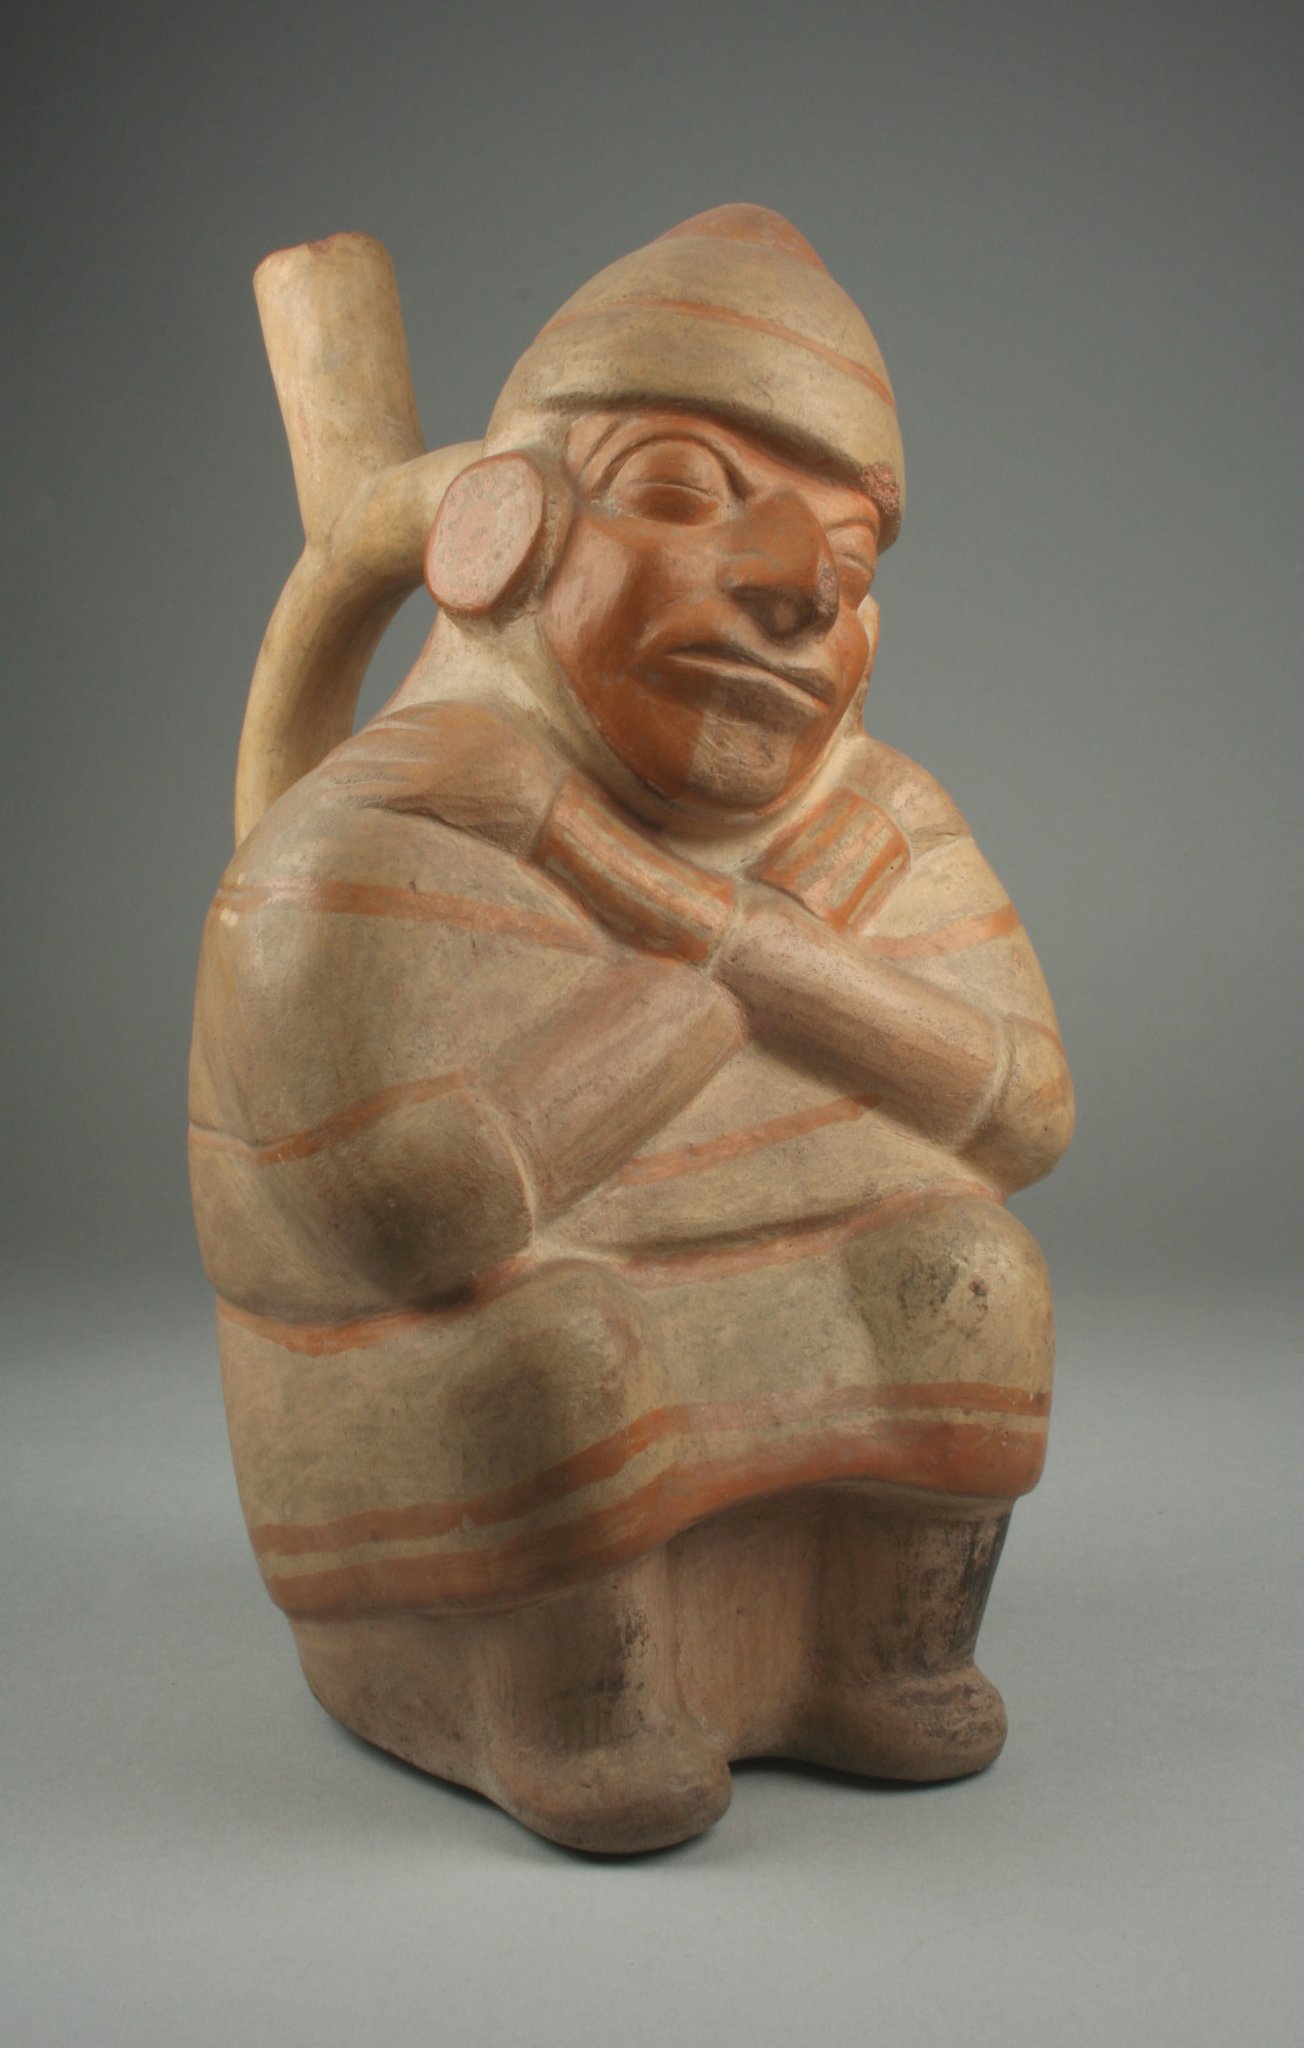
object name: bottle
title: Bottle, Sleeping Figure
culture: moche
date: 301-600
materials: ceramic, pigment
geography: peru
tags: sleeping,men